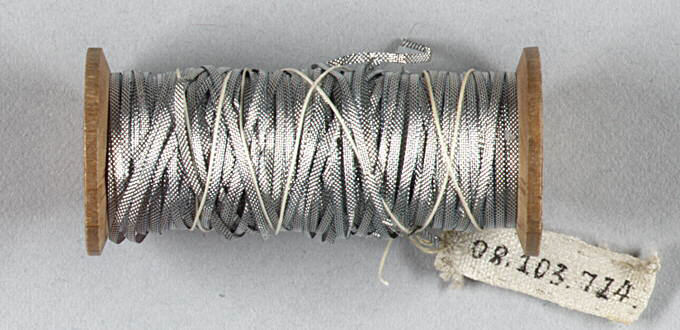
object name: thread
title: Tinsel and metal thread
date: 1601-1800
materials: metal thread